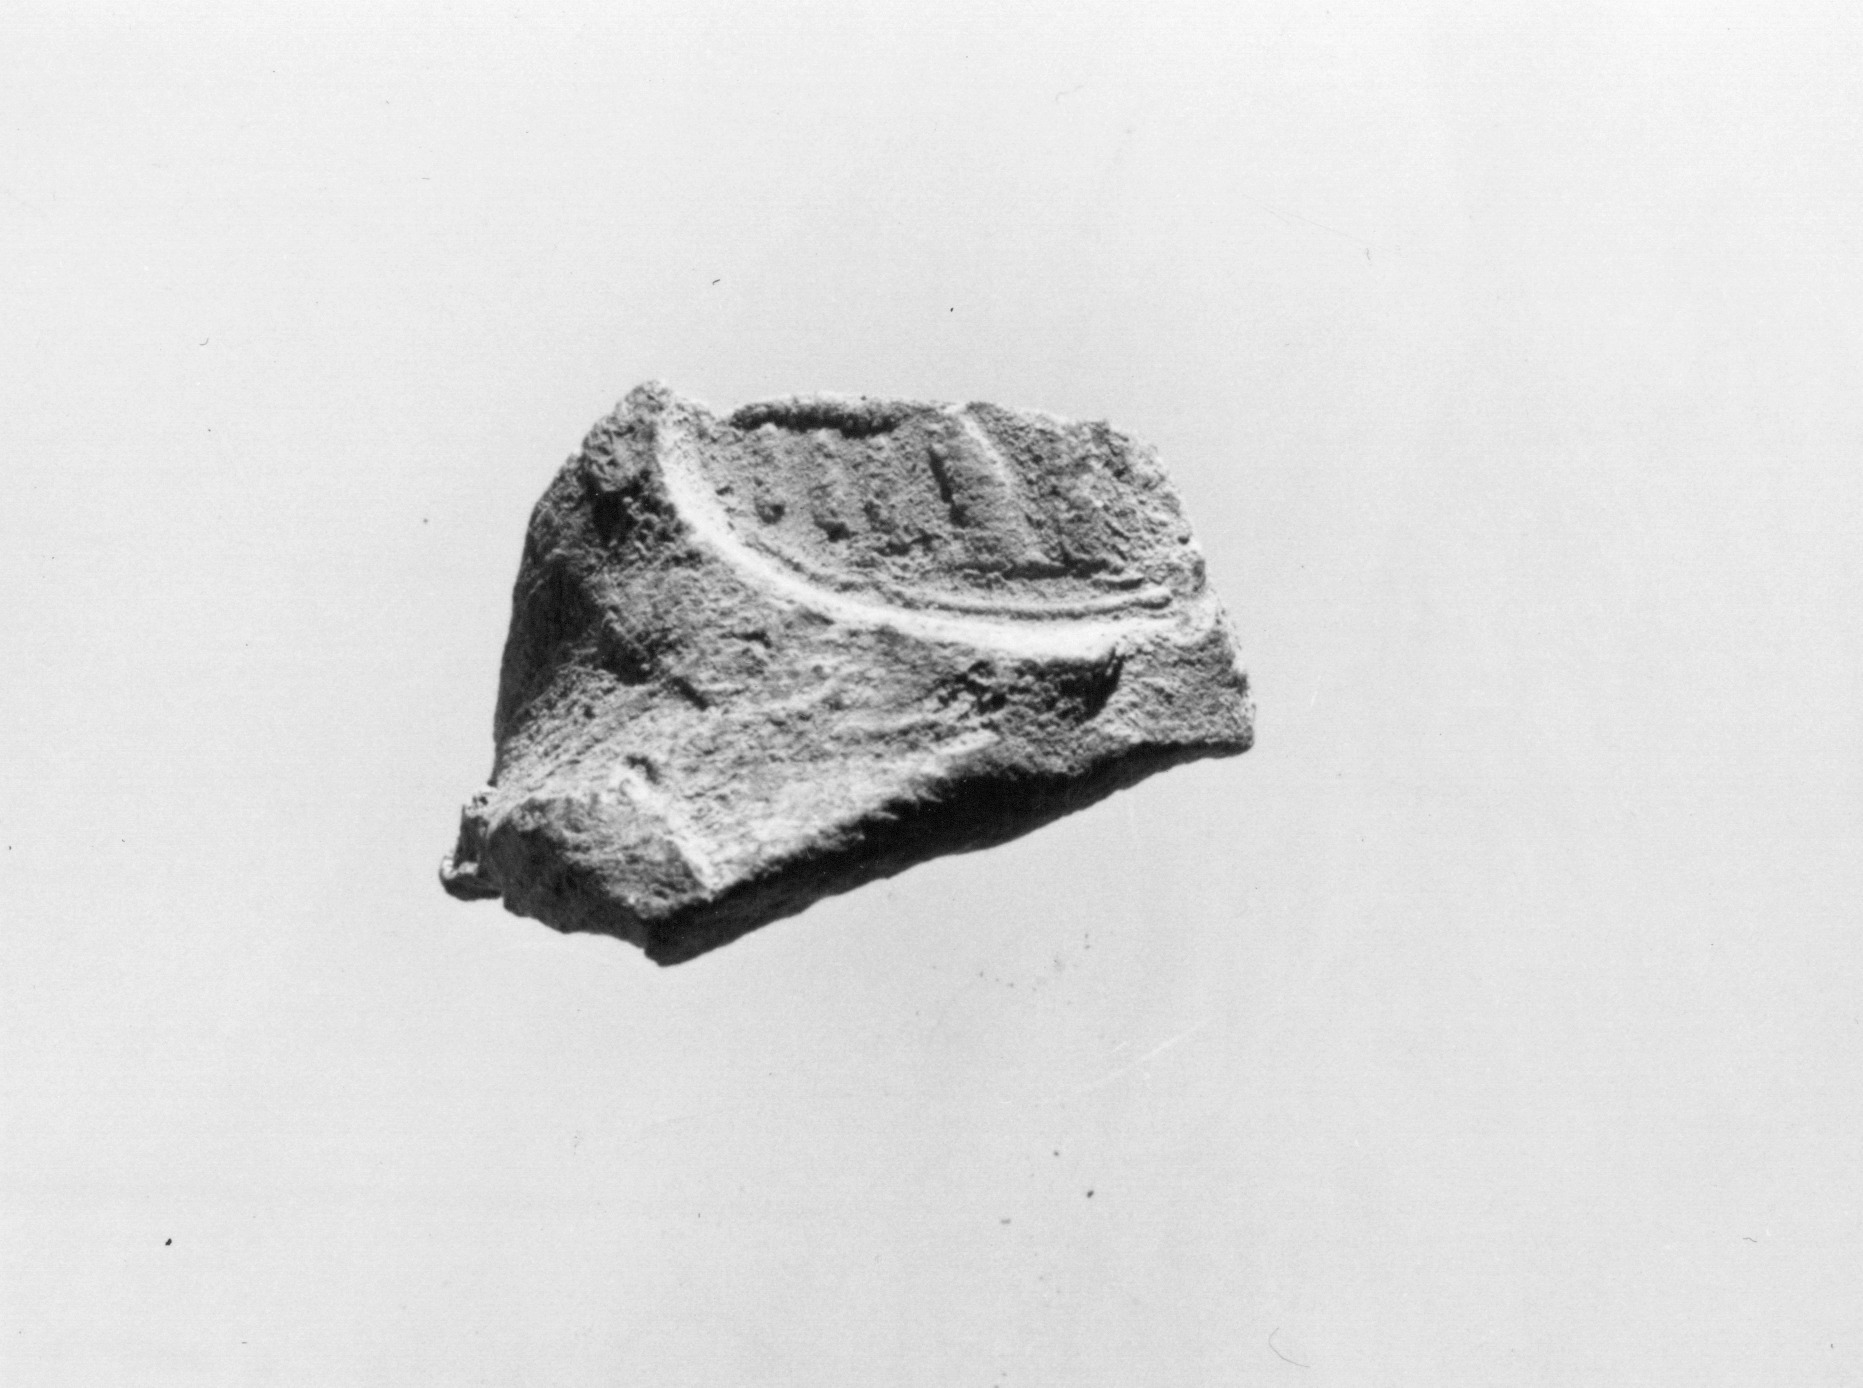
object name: sealing, nebmaatre, amenhotep iii, aten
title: Document Sealing With the Throne Name of Amenhotep III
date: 1390-1352 BCE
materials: mud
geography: egypt